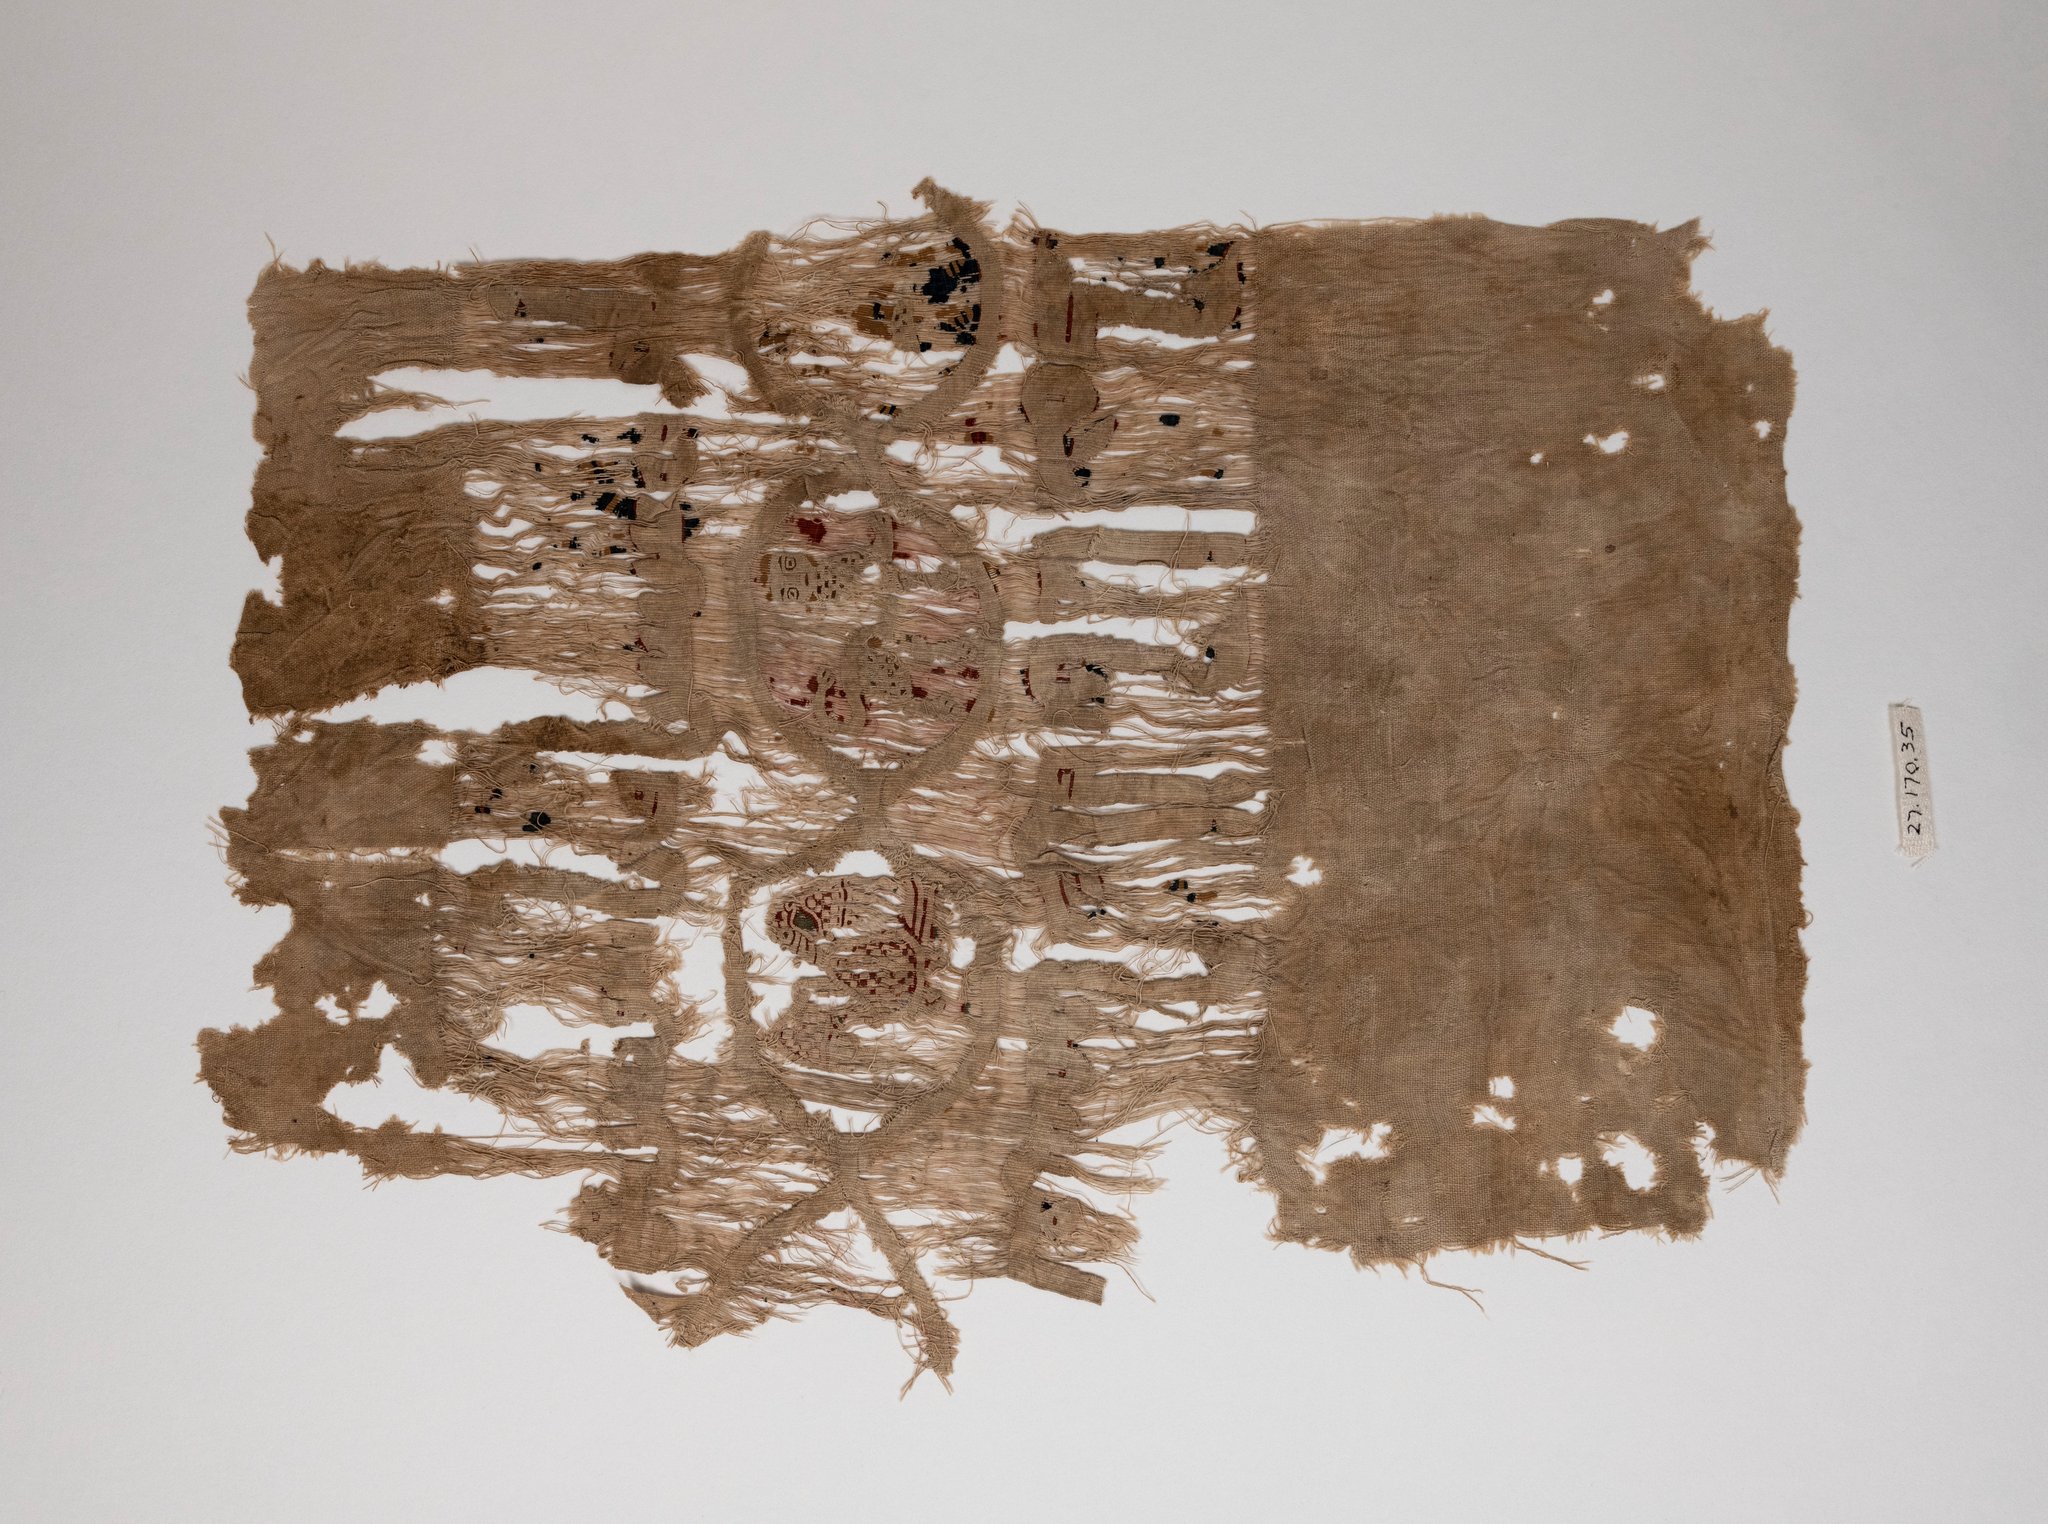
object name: textile fragment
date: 901-1100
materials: cotton, silk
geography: egypt